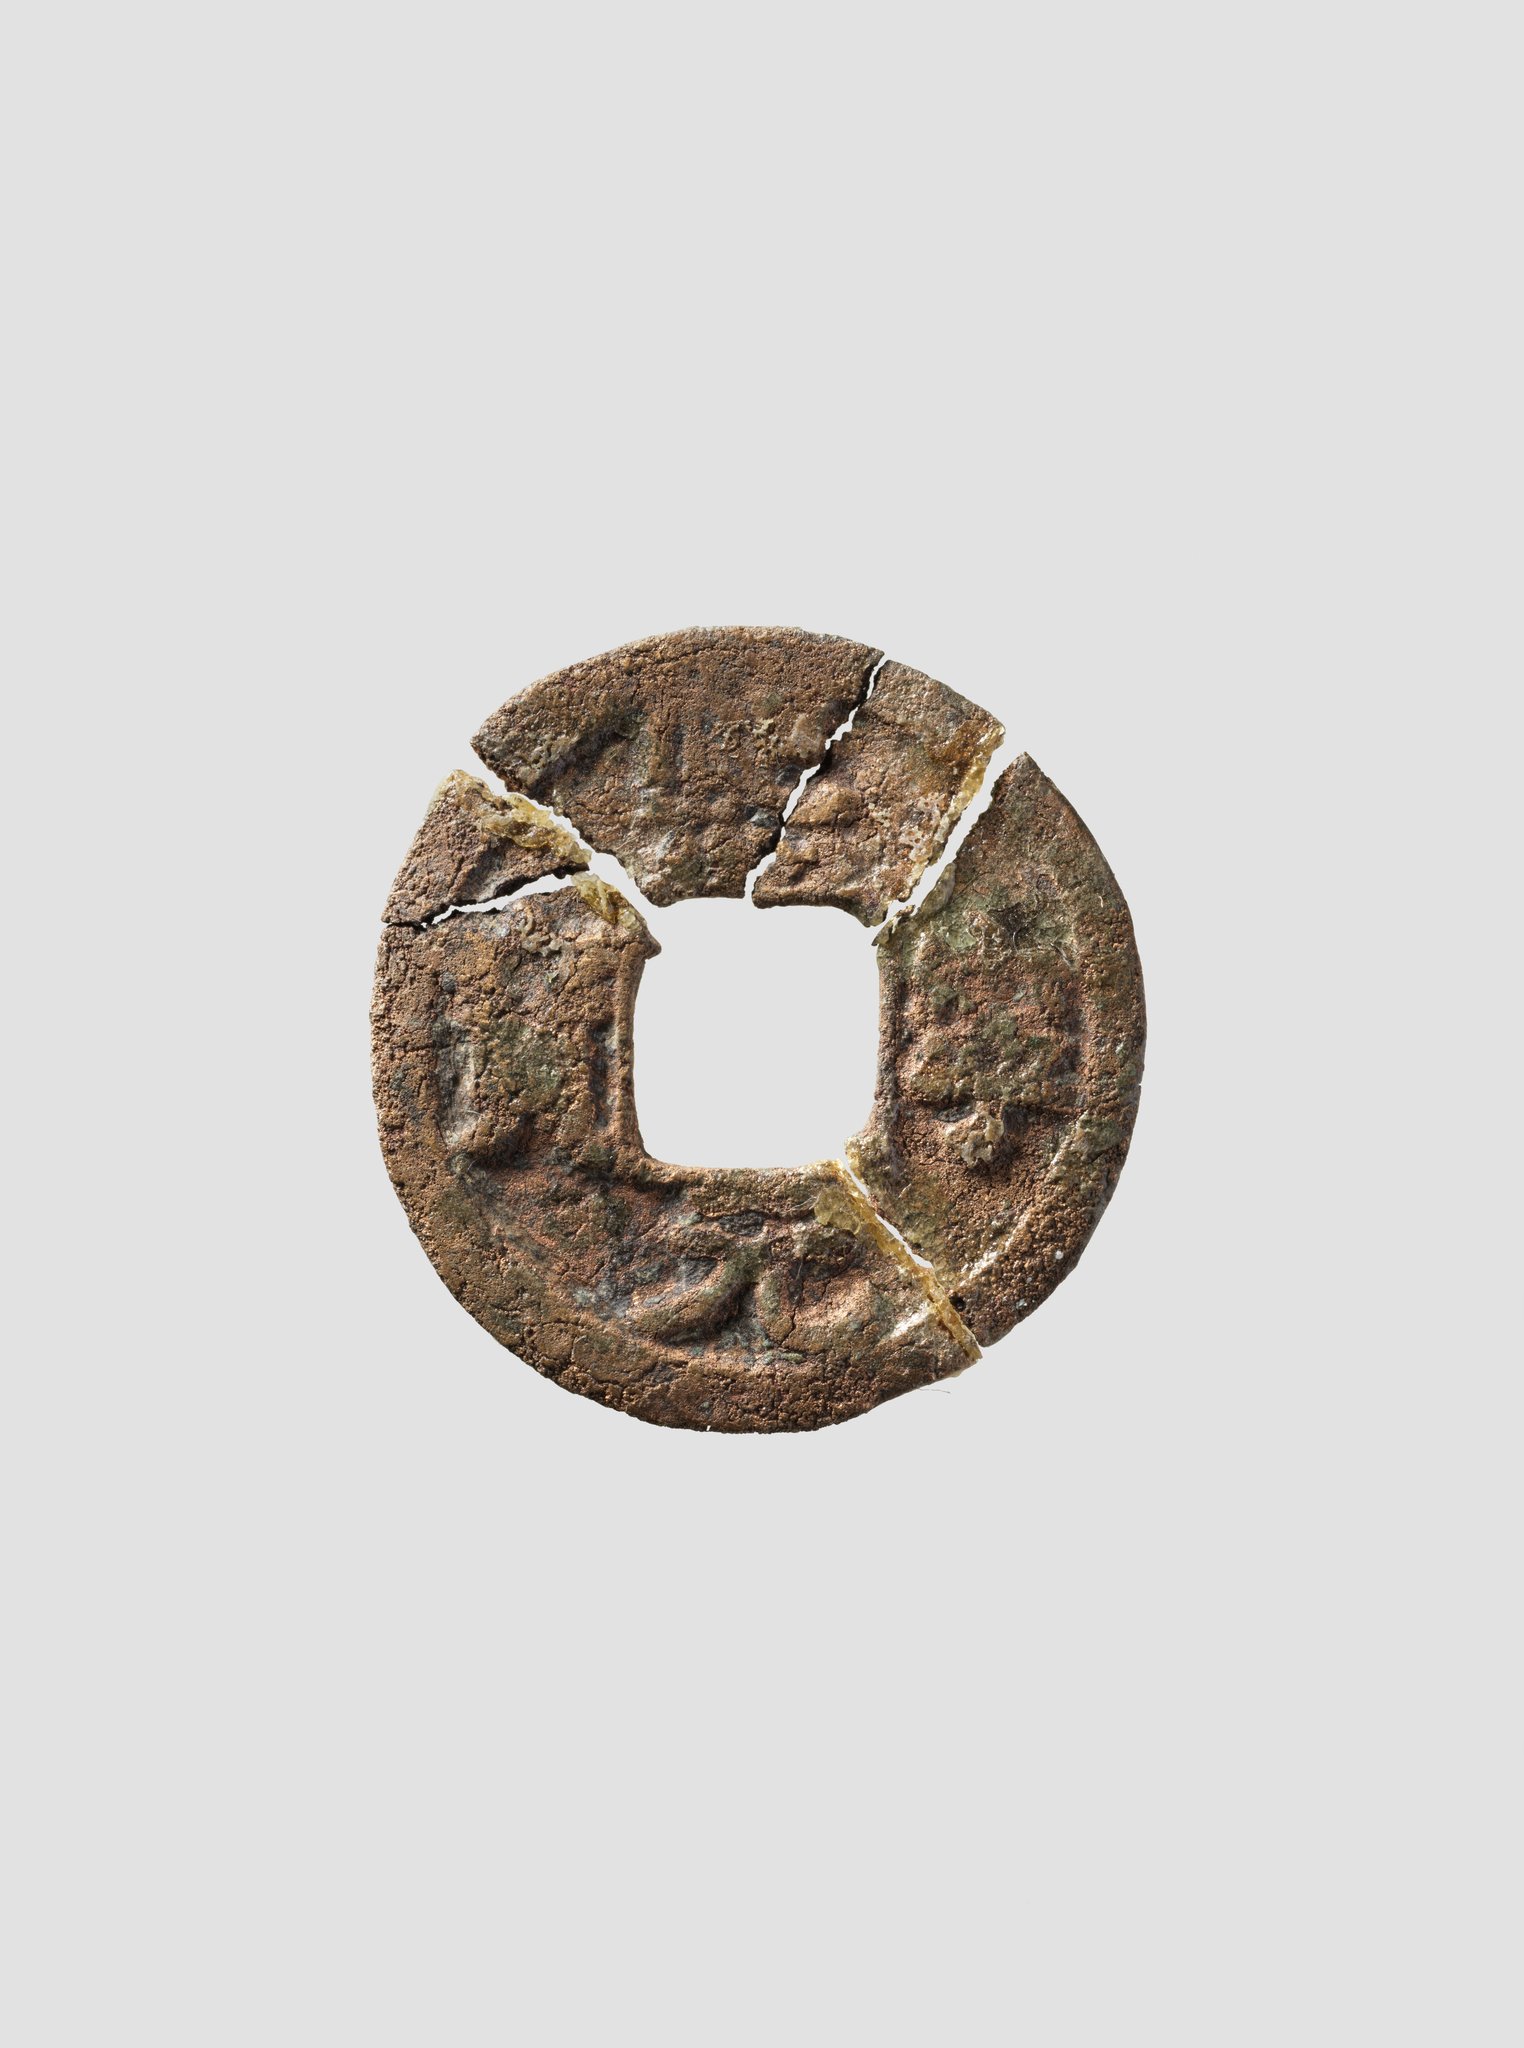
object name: coin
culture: chinese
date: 1068-1077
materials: copper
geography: iran